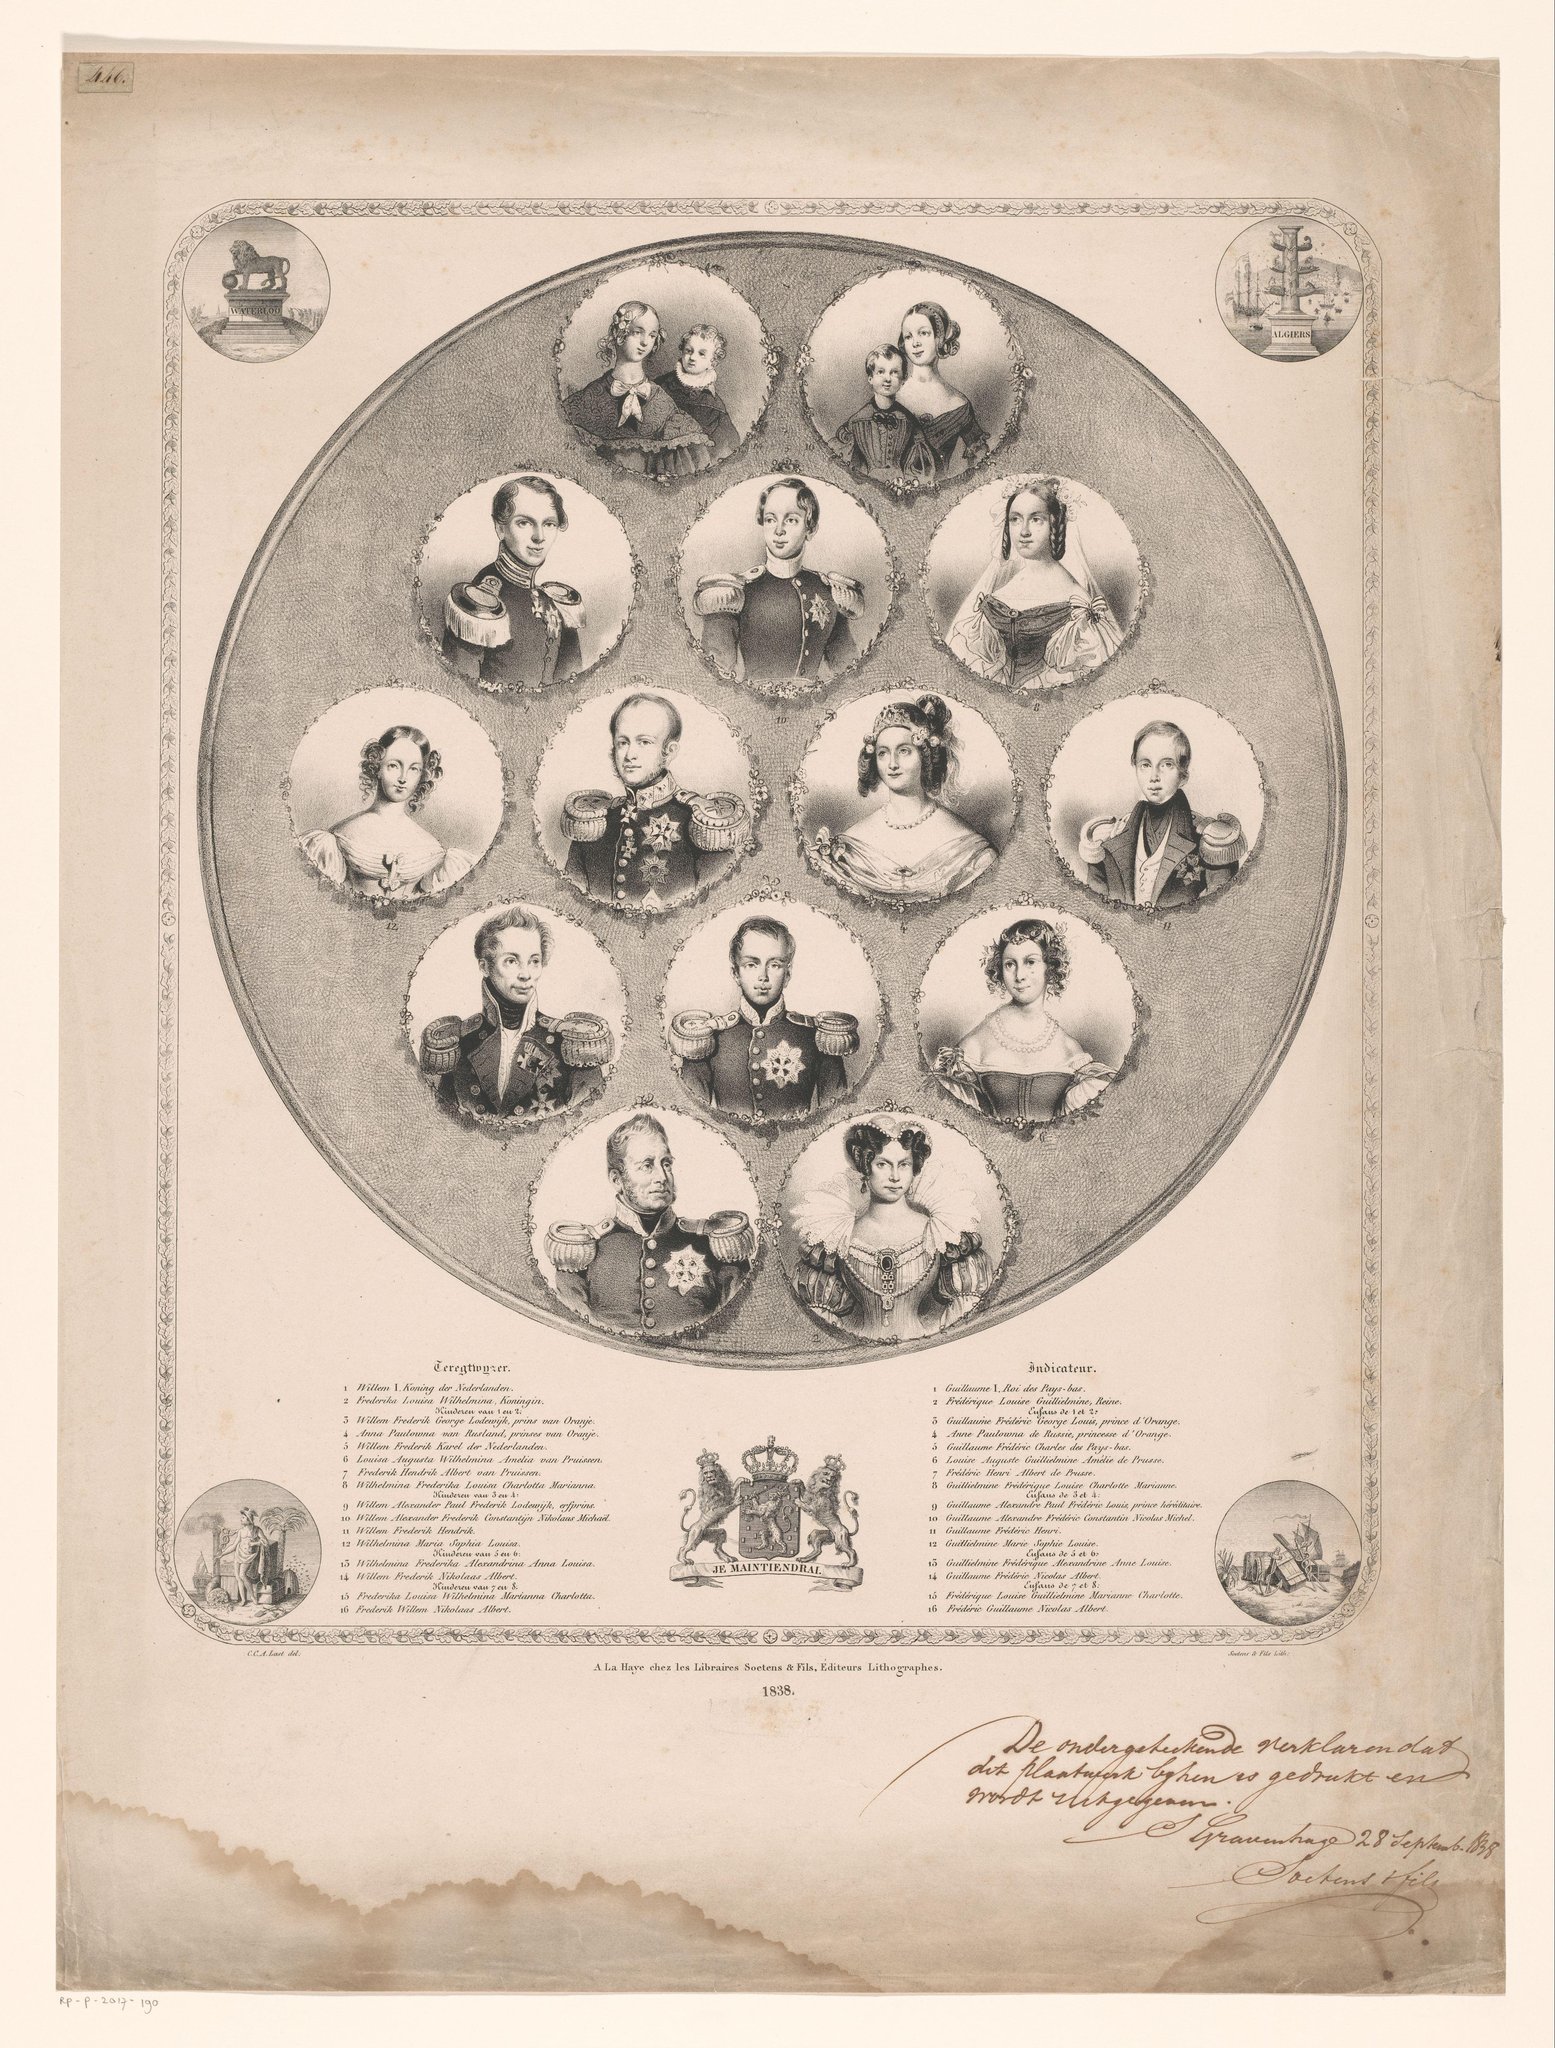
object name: print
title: Portretten van Koning Willem I, zijn vrouw Wilhelmina van Pruisen en hun kinderen en kleinkinderen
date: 1837-1840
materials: paper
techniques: lithograph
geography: the hague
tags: anna paulowna romanowa, berlin, william i of the netherlands, willem iii (koning der nederlanden), william ii of the netherlands, alexander (prins der nederlanden, prins van oranje-nassau), hendrik (prins der nederlanden), frederik (prins der nederlanden), voorburg, marianne (prinses der nederlanden), wilhelmina frederica louisa (koningin der nederlanden), netherlands, waterloo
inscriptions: : ‘De ondergeteekende verklaren dat / dit plaatwerk bij hen is gedrukt en / wordt uitgegeven / S Gravenhage 28 september 1838 / Soetens&Fils’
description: Linksboven een standbeeld van een Nederlandse leeuw ter herinnering aan de Slag bij Waterloo. Rechtsboven een zeegezicht met een monument ter herinnering aan het bombardement van Algiers in 1816. Linksonder een personificatie van de handel en rechtsonder attributen die verwijzen naar de zeevaart en handel. Onder de portretten twee legenda's met de namen van de geportretteerden, in het Nederlands en Frans. Tussen de legenda's het wapen van de Staat der Nederlanden. Om het geheel een rand van eikenbladeren.